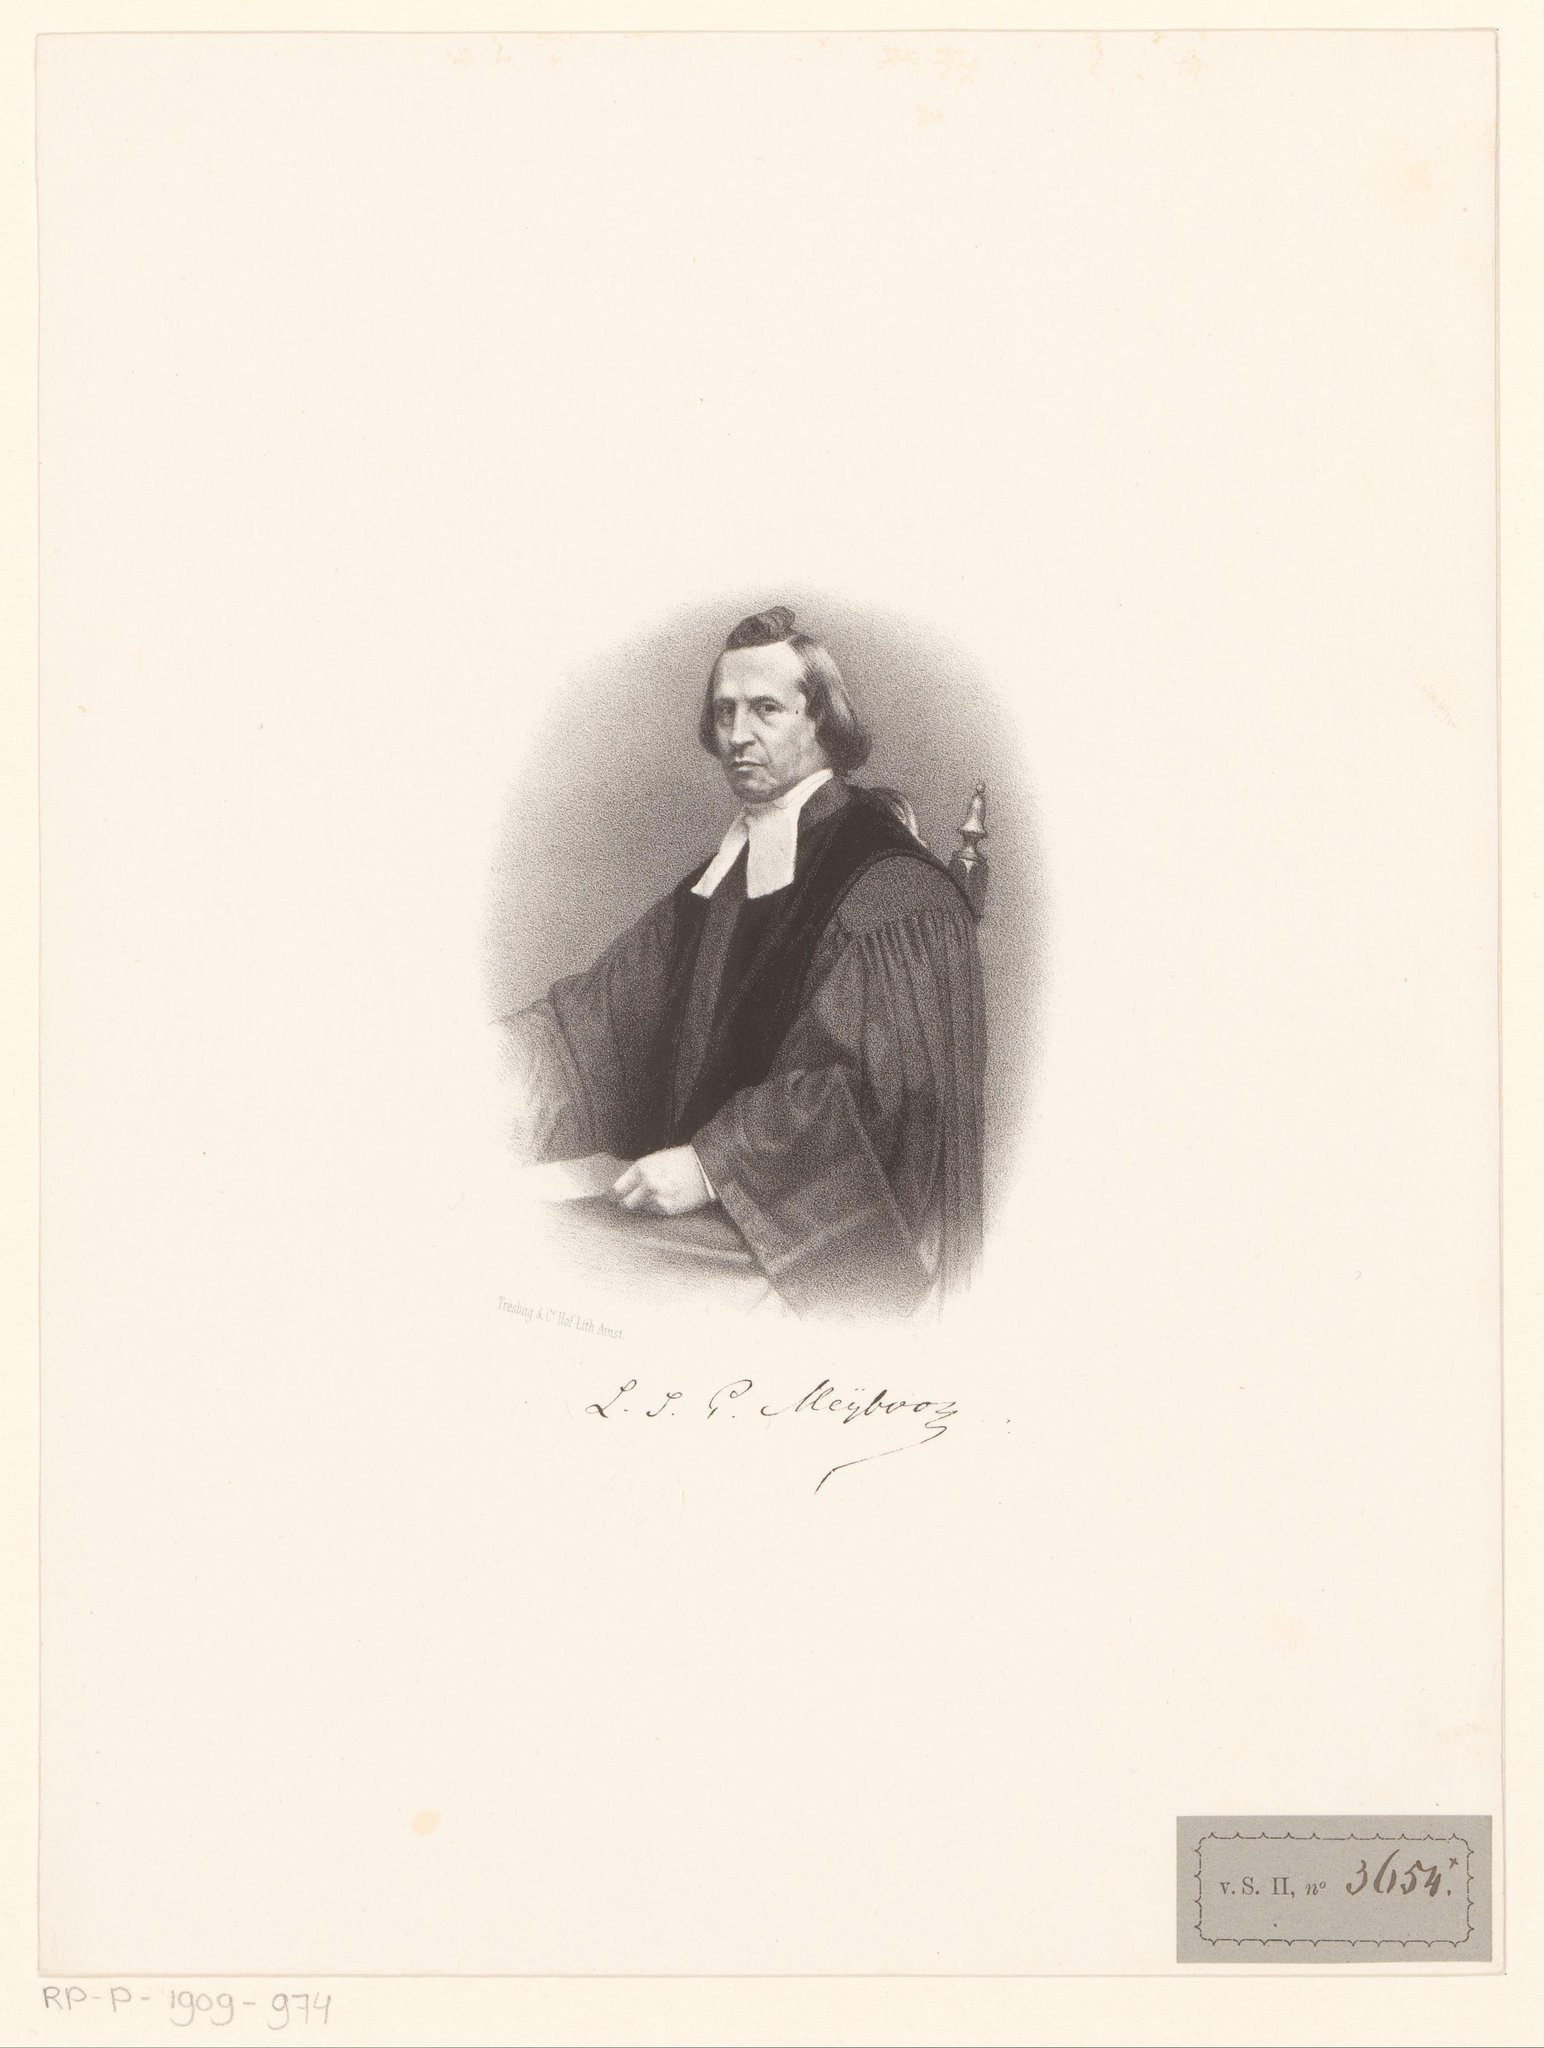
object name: print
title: Portret van Louis Suson Pedro Meyboom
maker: Anonymous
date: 1858-1874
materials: paper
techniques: lithograph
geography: amsterdam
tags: historical persons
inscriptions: collector's mark: Lugt 2228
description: Onder het portret de signatuur van de geportretteerde.